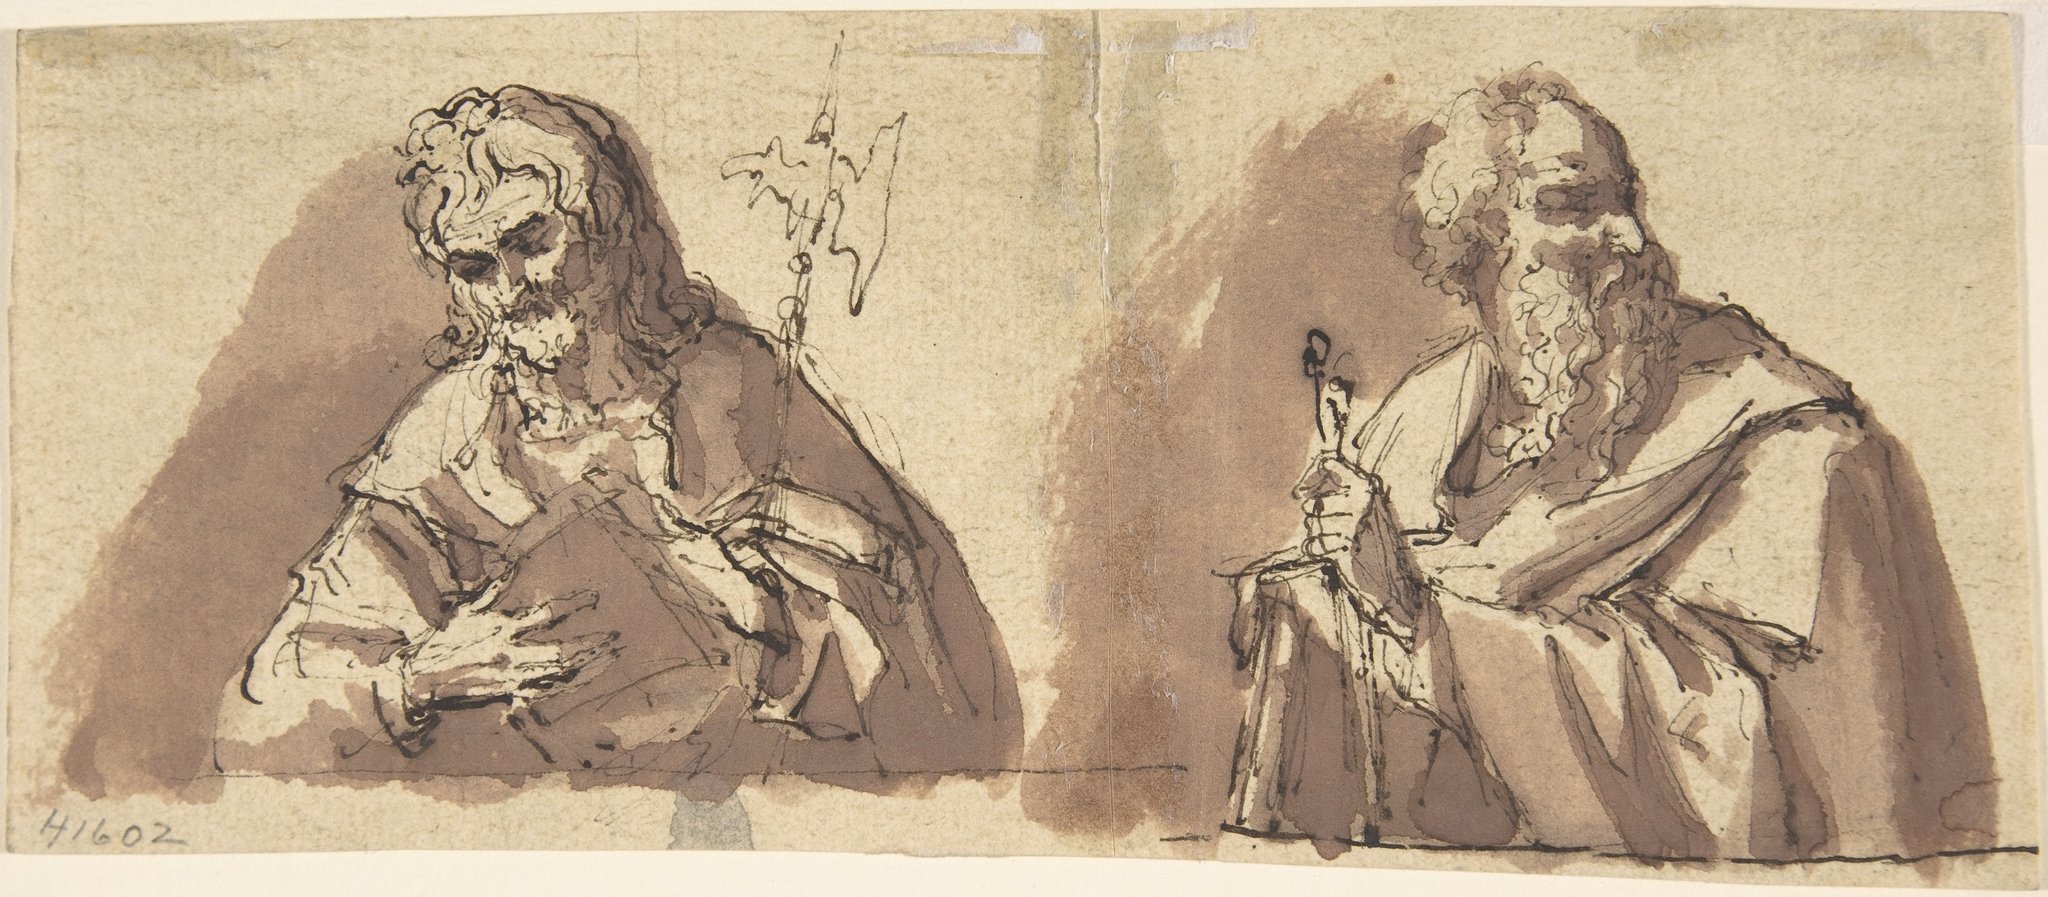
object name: drawing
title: Christ (?) and an Apostle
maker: anonymous, italian, 18th century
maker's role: artist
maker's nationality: italian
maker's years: 1700-1800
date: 1701-1800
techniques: pen, wash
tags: apostles